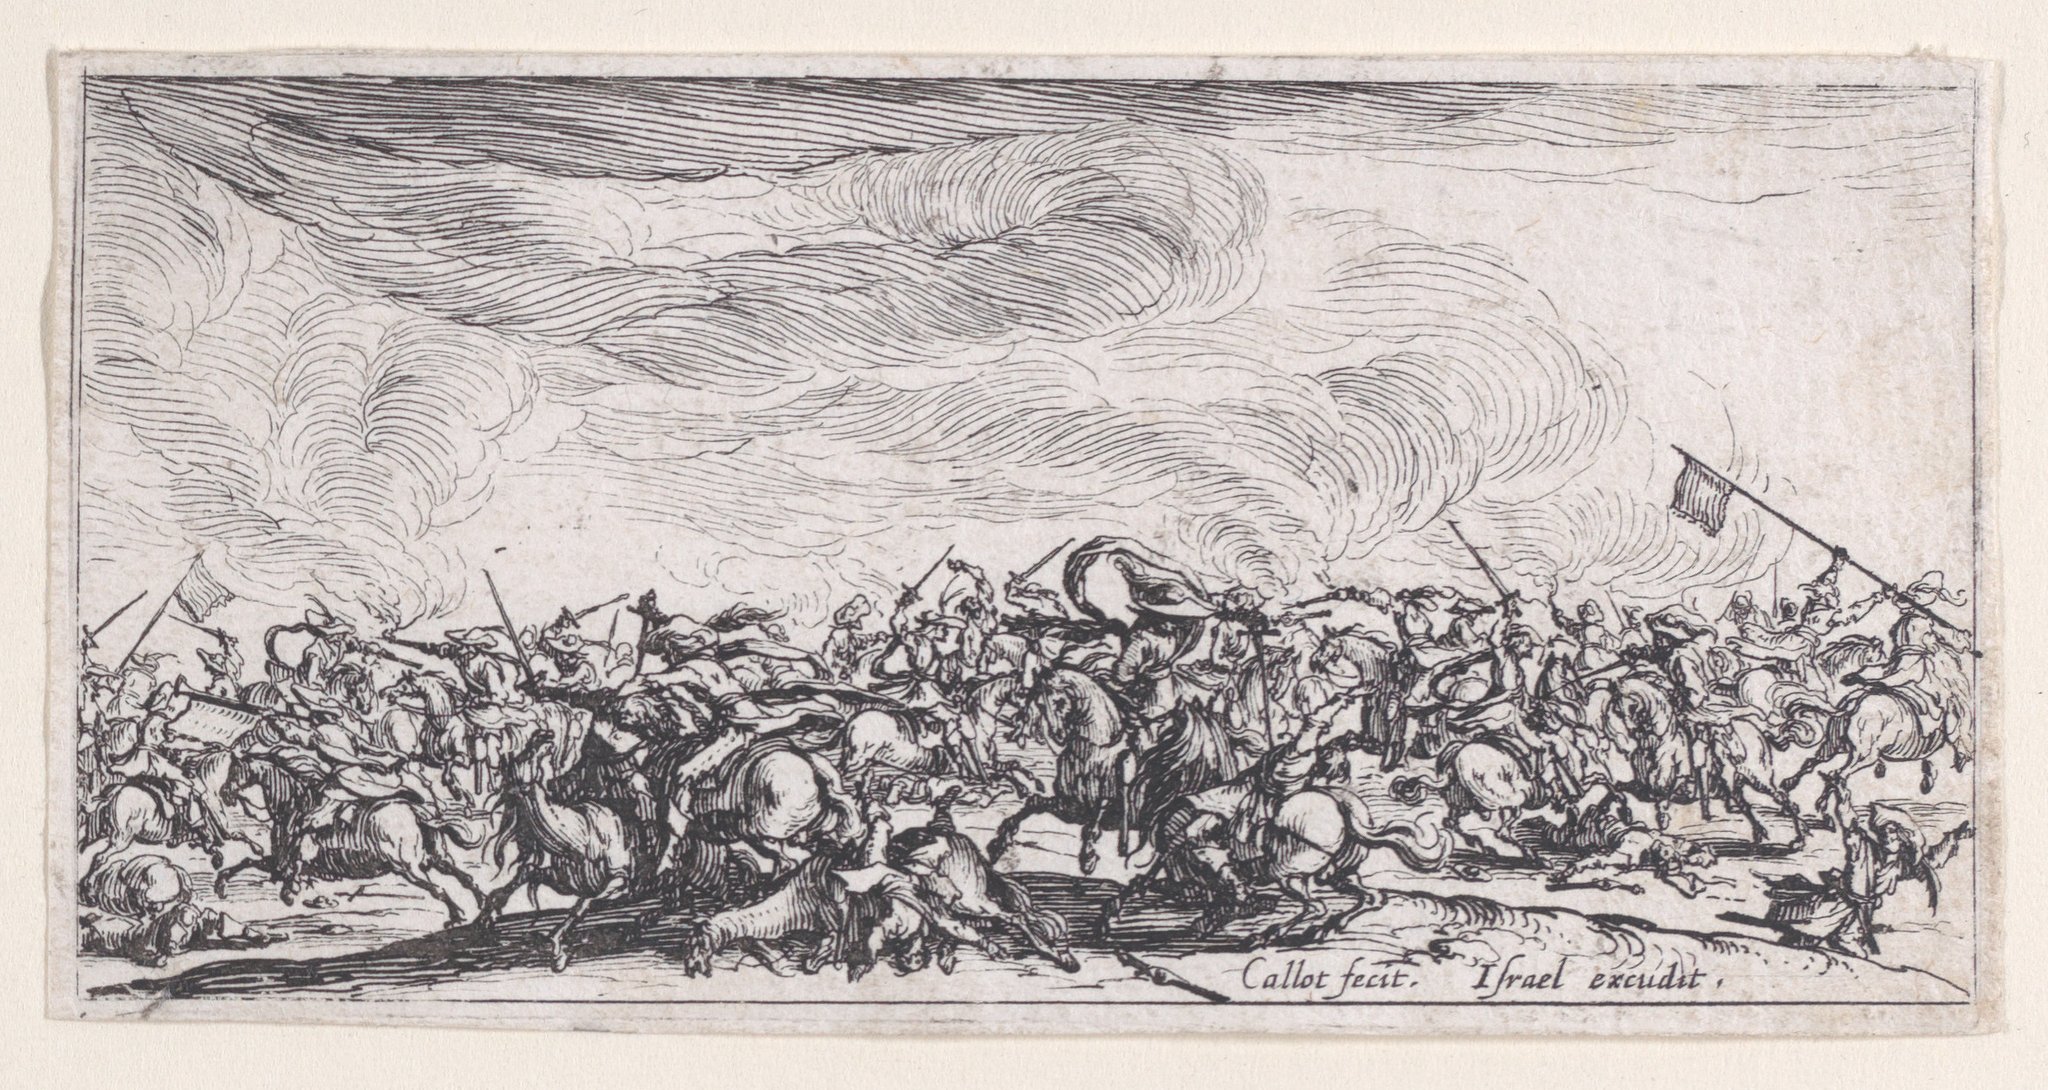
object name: print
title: Le Combat a l'Épée (The Combat with Swords), from "Les Combats de Cavalerie" (The Cavalry Combats)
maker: jacques callot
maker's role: artist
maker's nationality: french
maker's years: 1592-1635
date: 1632-1634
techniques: etching